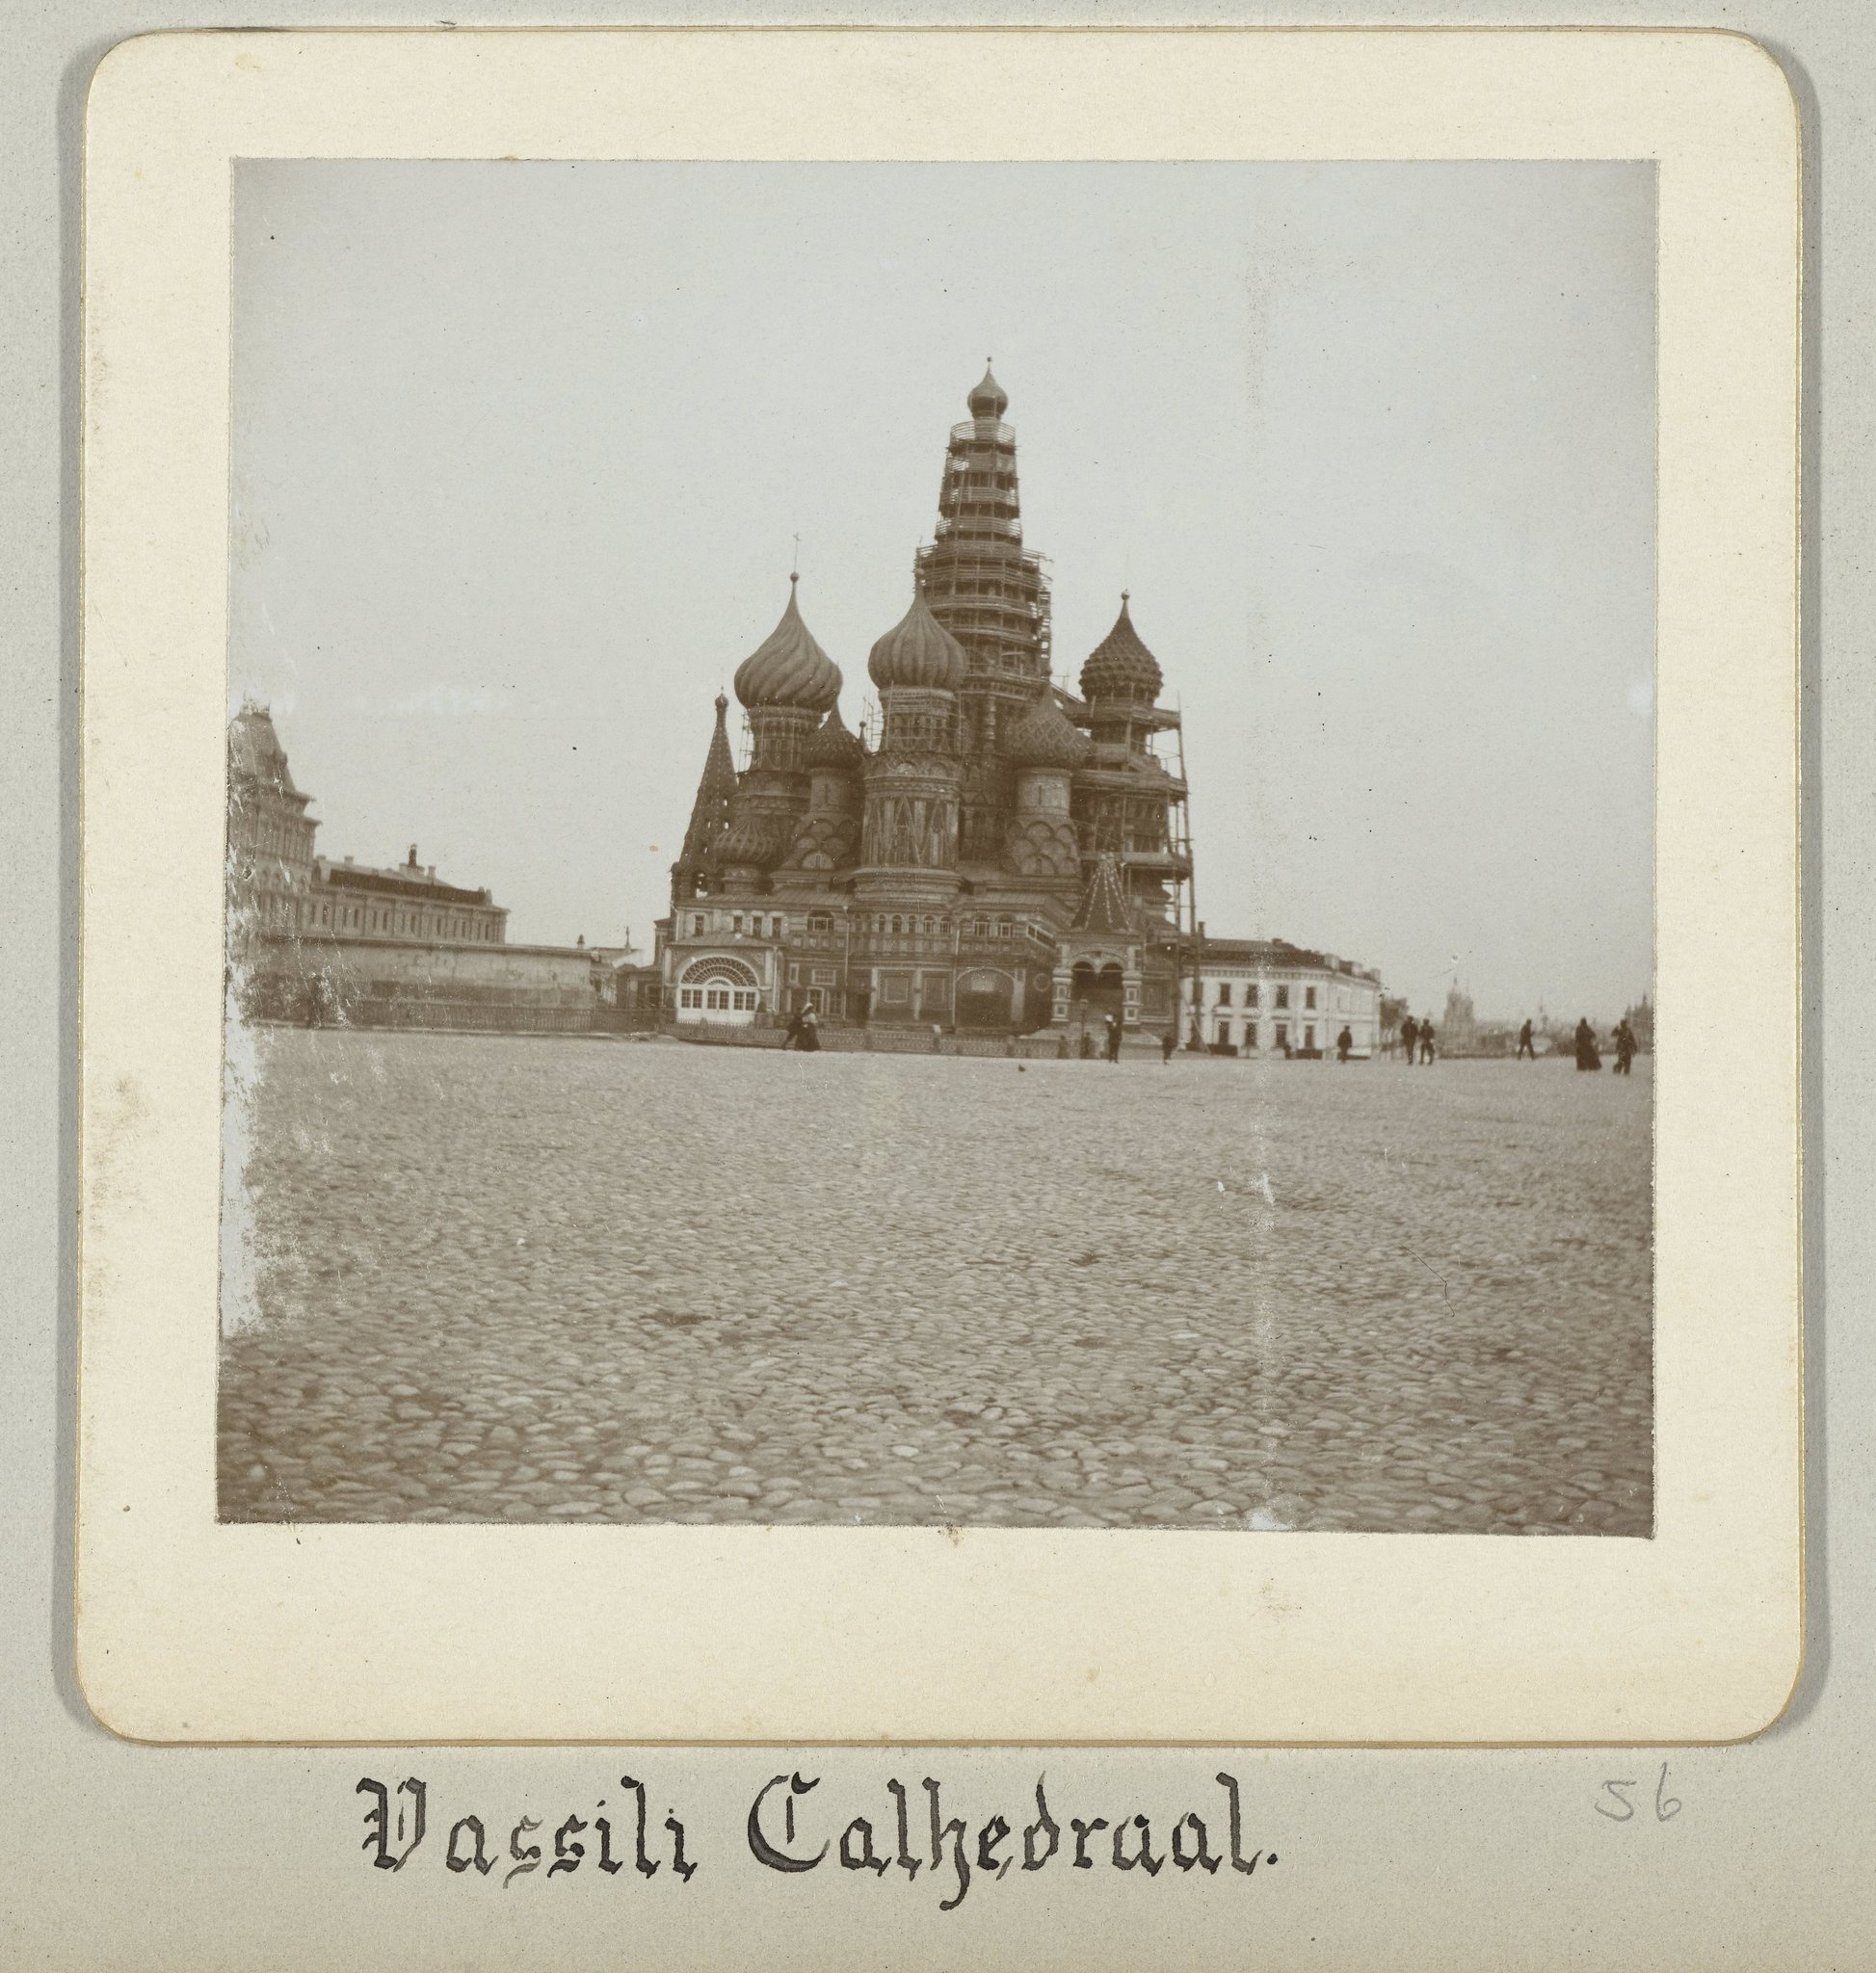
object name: photograph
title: Basiliuskathedraal op het Kremlin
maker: henry pauw van wieldrecht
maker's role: fotograaf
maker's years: 1863-1912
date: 1898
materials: paper, photographic support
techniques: albumen print